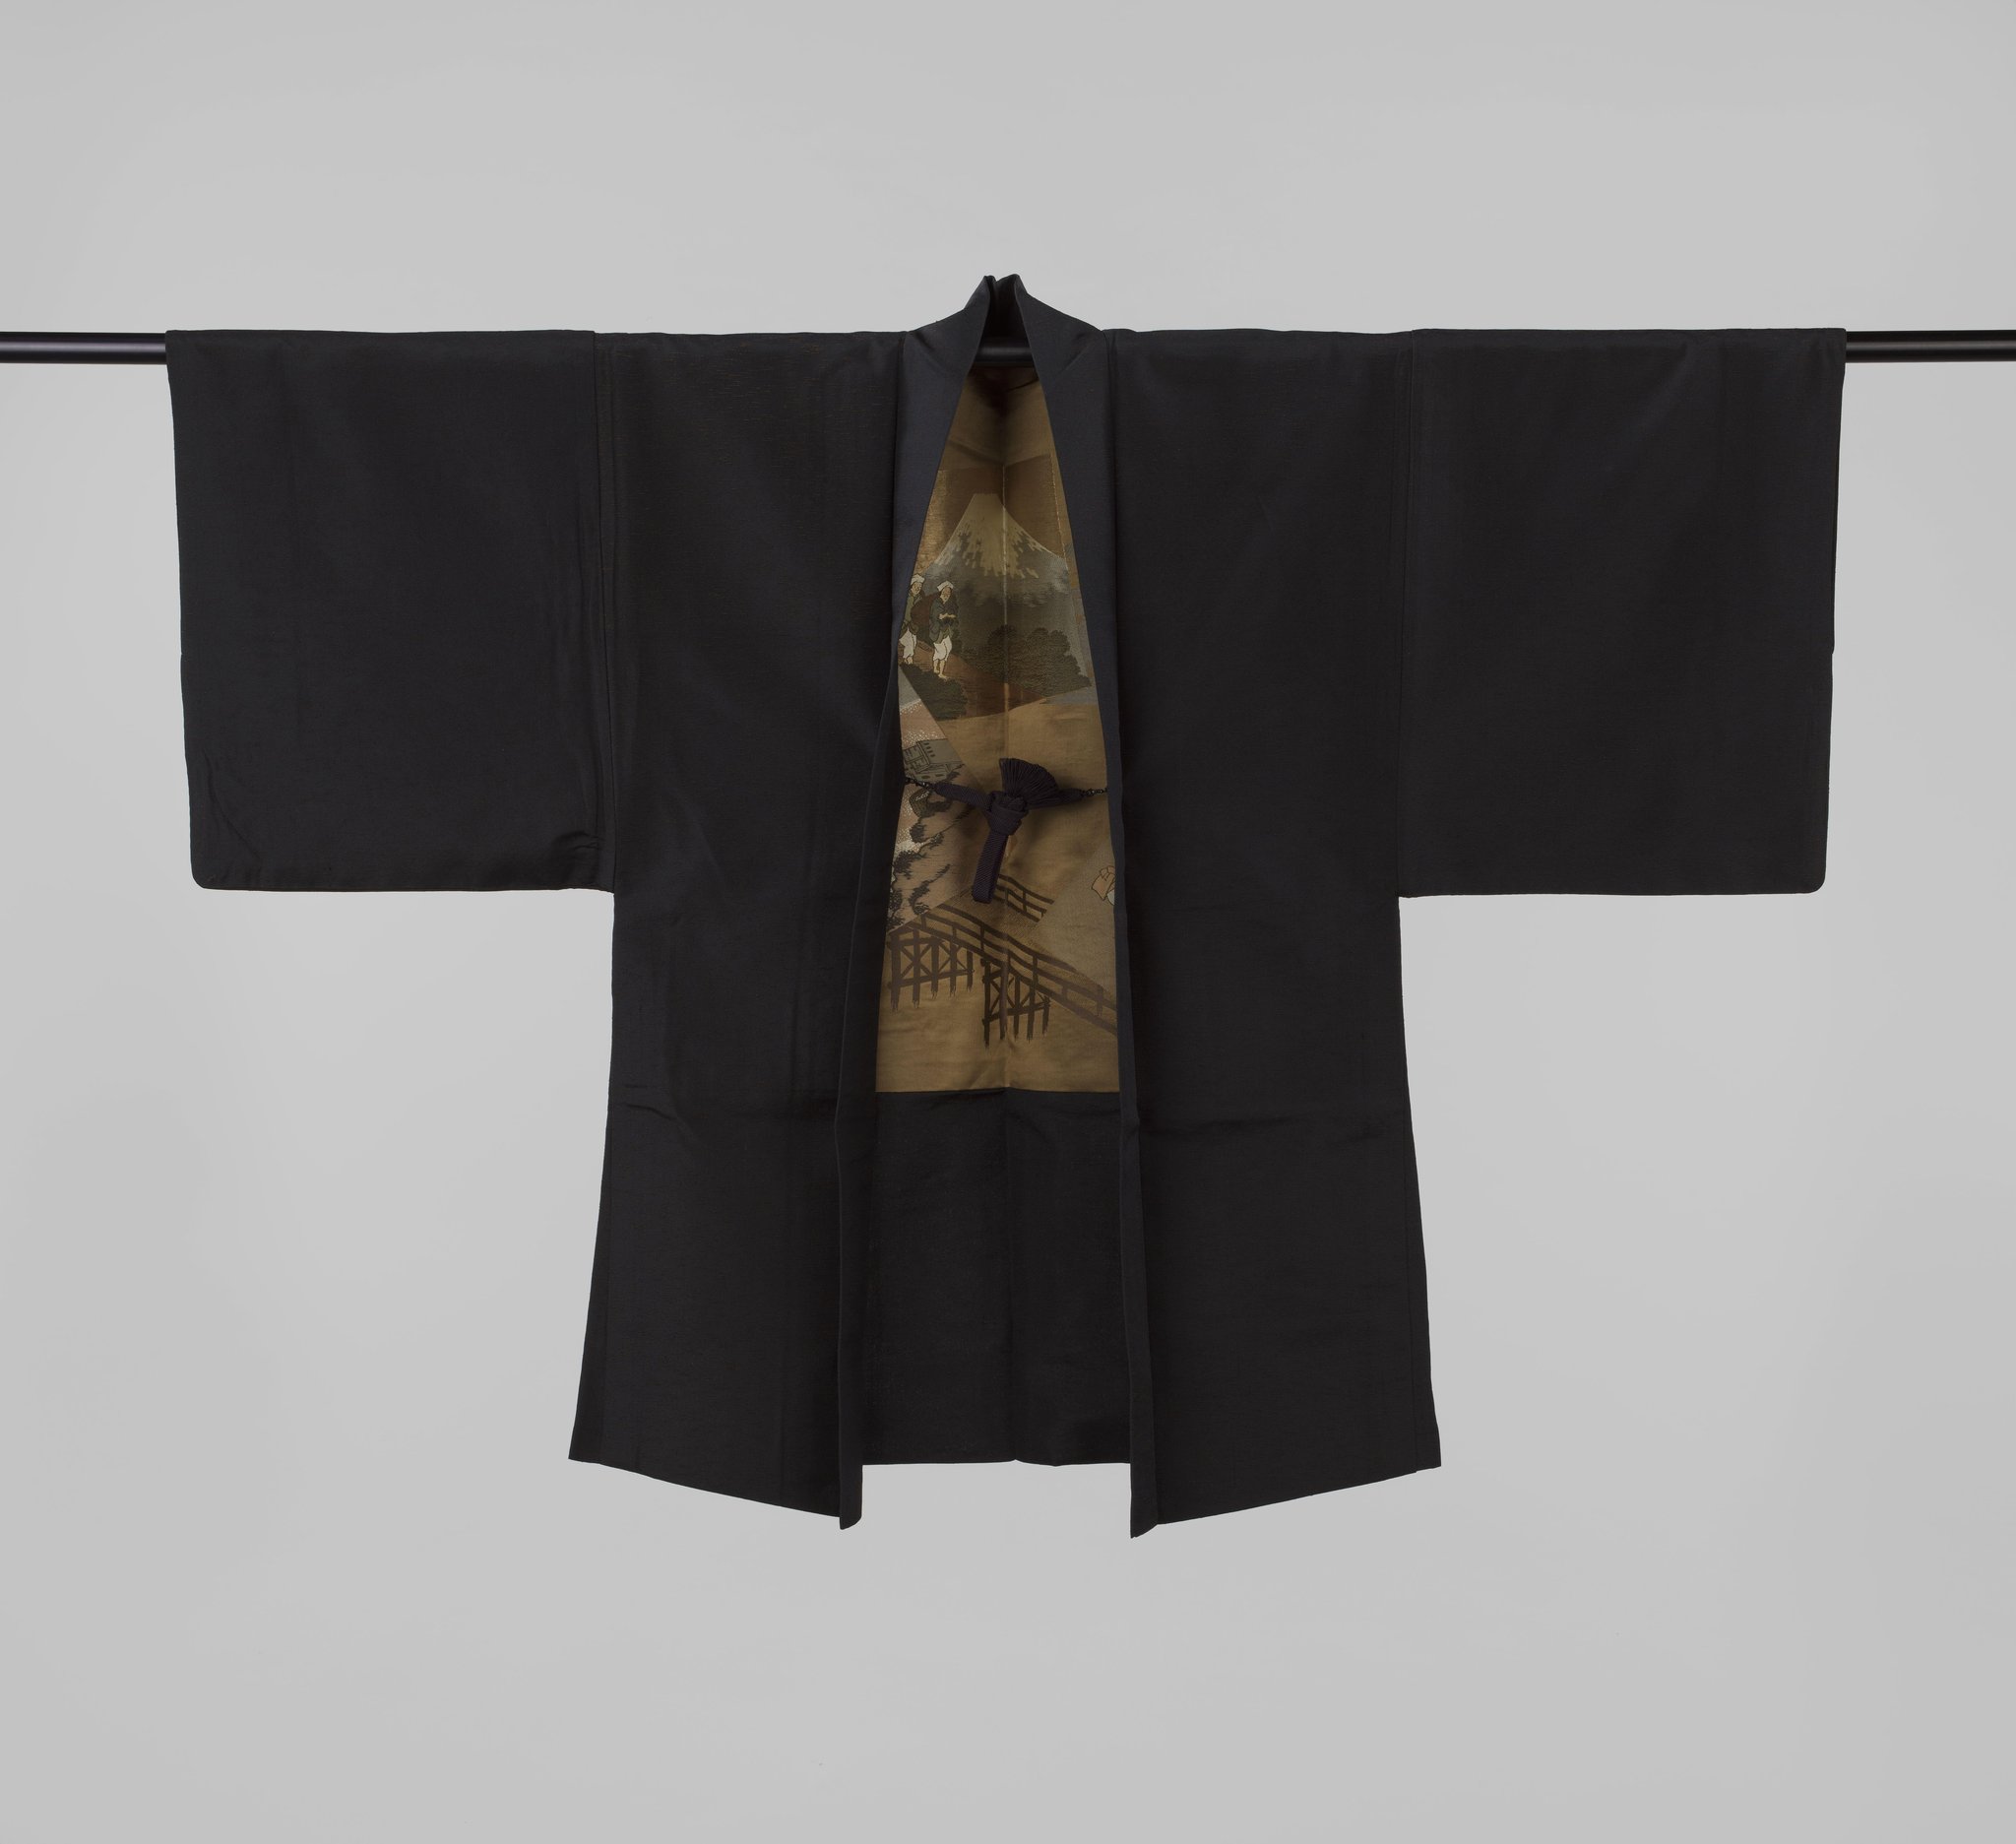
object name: kimono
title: Mannen haori met scenes rond Edo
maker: Anonymous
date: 1920-1940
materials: silk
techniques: weave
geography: japan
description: Haori voor een man met een versiering op de voering van drie elkaar gedeeltelijk overlappende rechthoekige vlakken tegen de achtergrond van een afbeelding van een brug, met voorstellingen van het bewerken van deeg voor rijstcake (mochi), vrouwen die brandhout dragen bij de berg Fuji, en het verzamelen van schelpen aan de kust. De brug is over de Edo Rivier. Zwarte ruwe zijde (tsumugi) met brokaat geweven versiering.